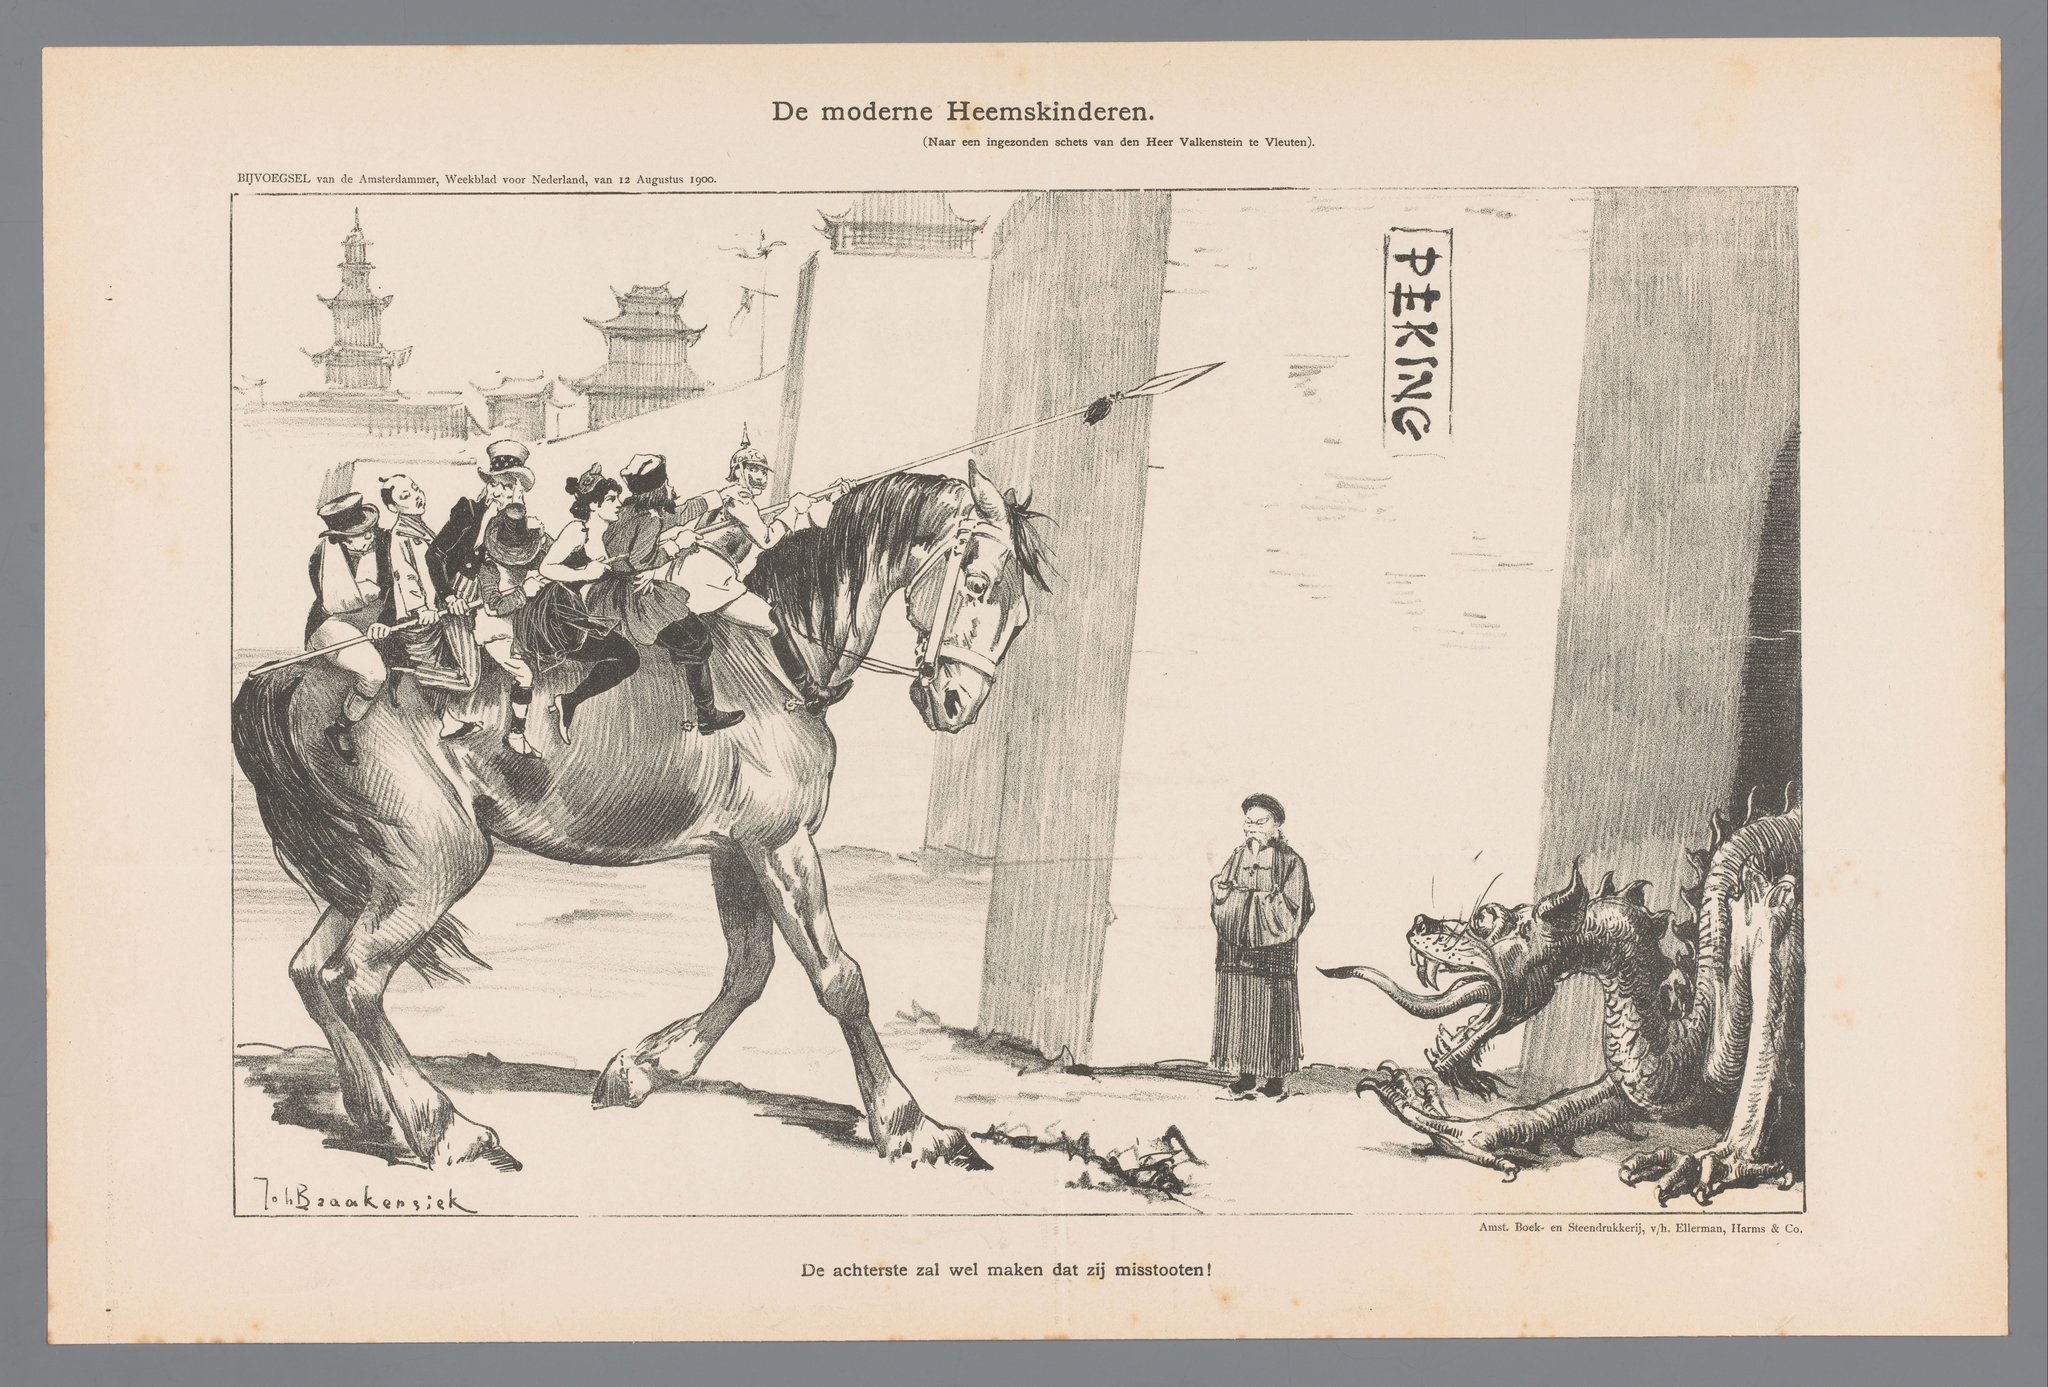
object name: cartoon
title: De moderne Heemskinderen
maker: johan braakensiek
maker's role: draughtsman, print maker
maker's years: 1858-1940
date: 1900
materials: paper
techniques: lithograph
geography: amsterdam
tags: china, politician, personifications of countries, nations, states, districts, etc., ruler, sovereign, political caricatures and satires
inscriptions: date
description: Prent uit het bijvoegsel van: De Amsterdammer. Weekblad voor Nederland, 12 augustus 1900.